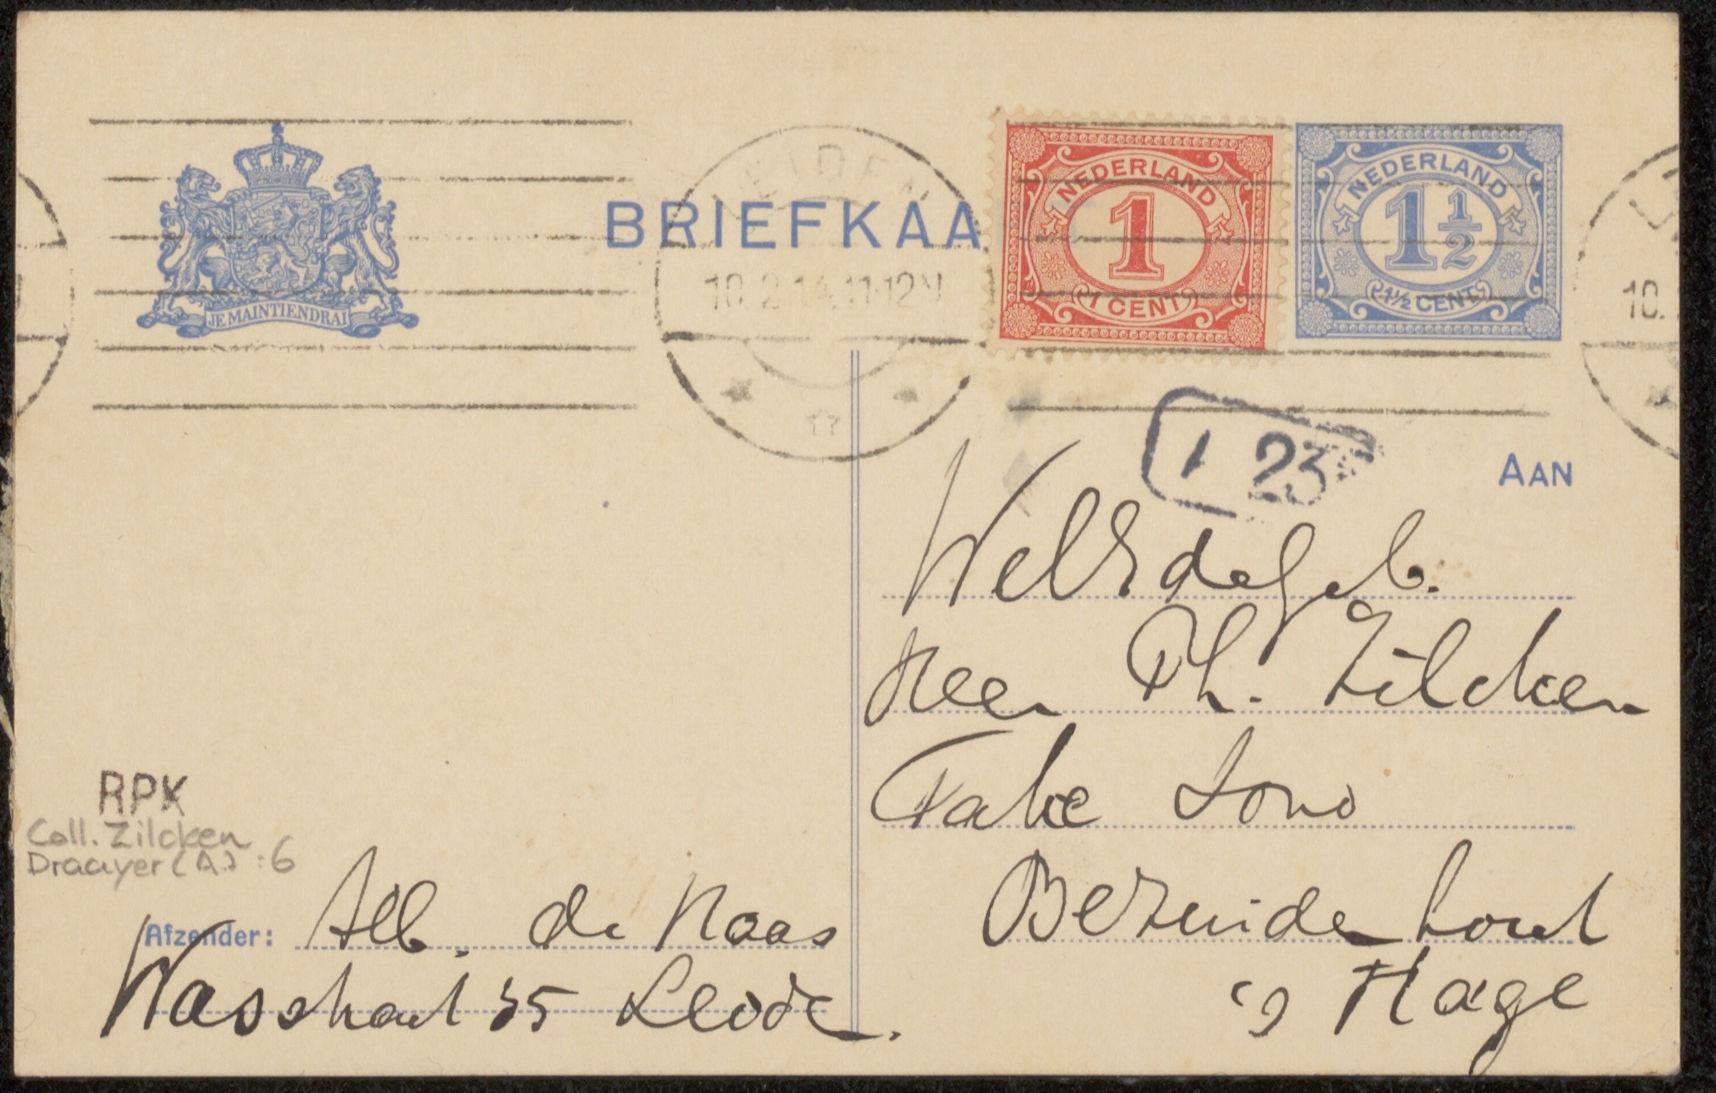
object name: postcard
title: Briefkaart aan Philip Zilcken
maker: albertine draaijer-de haas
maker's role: kunstcriticus, schrijver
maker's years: 1875-1952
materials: cardboard, ink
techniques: pen, writing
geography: leiden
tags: the hague, painter, draughtsman, philip zilcken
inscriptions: collector's mark: ‘RPK’